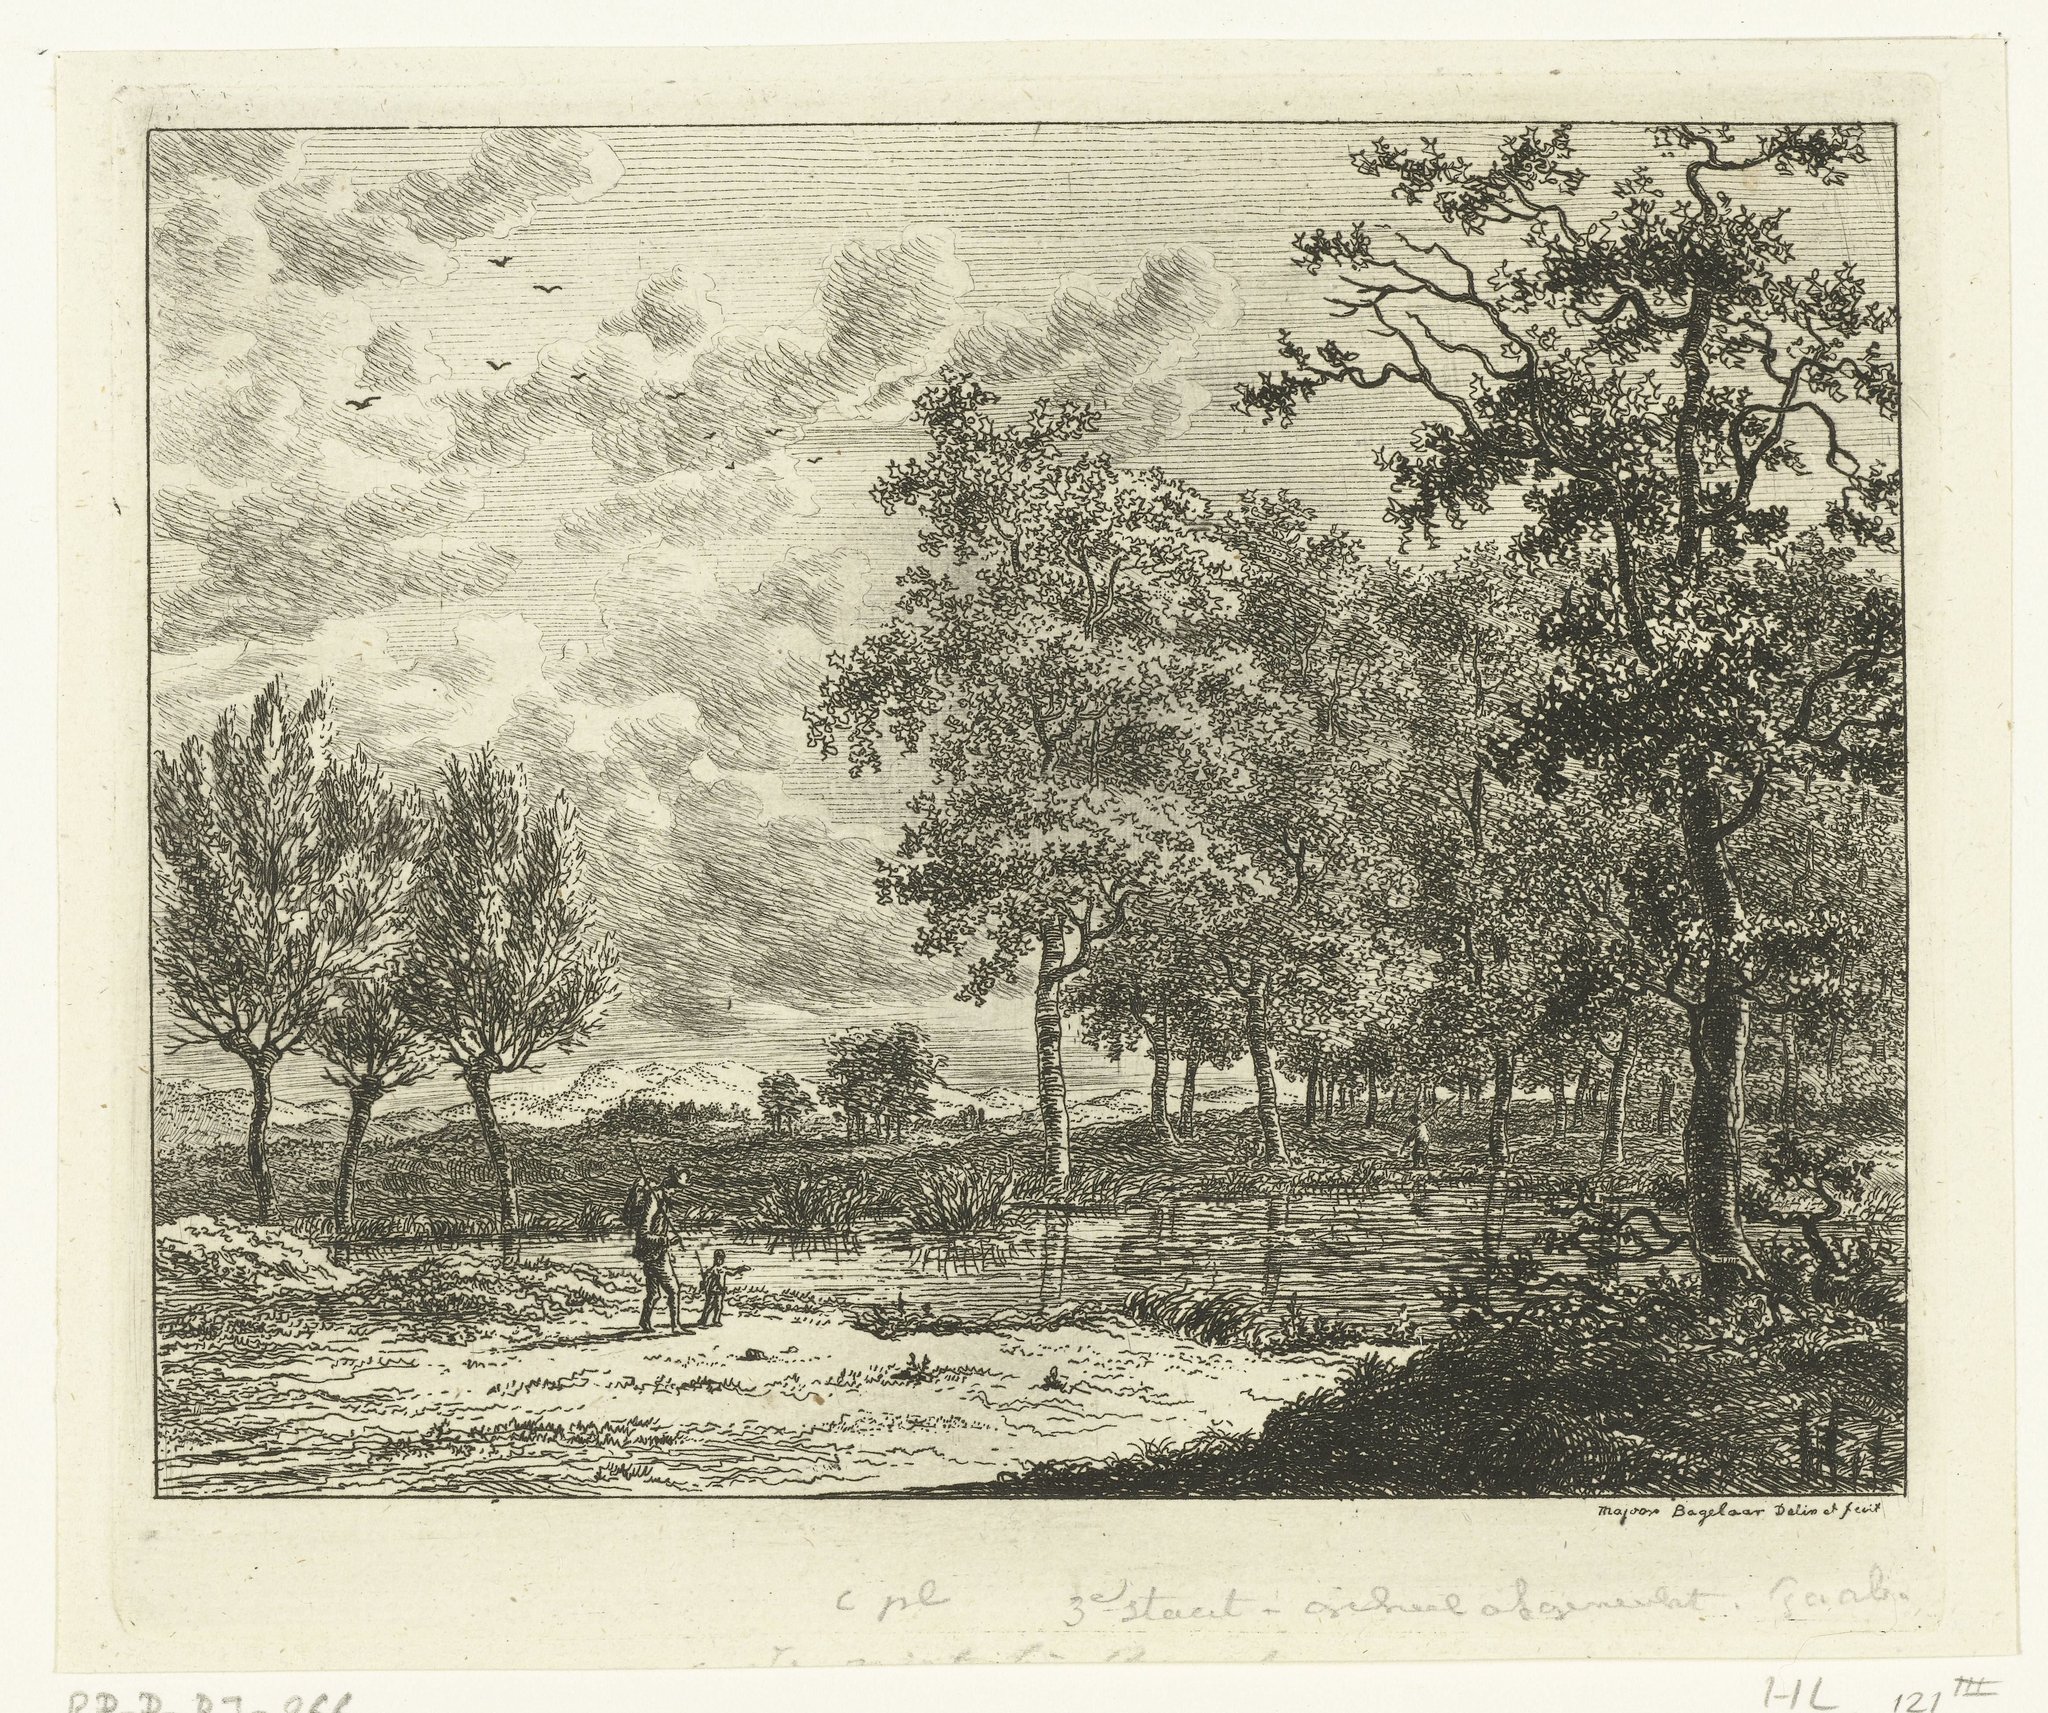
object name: print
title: Landschap met een man en een jongetje bij een rivier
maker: ernst willem jan bagelaar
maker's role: draughtsman, print maker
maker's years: 1775-1837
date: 1798-1837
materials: paper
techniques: drypoint, etching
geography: netherlands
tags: landscapes with waters, waterscapes, seascapes (in the temperate zone)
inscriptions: collector's mark: Lugt 2228